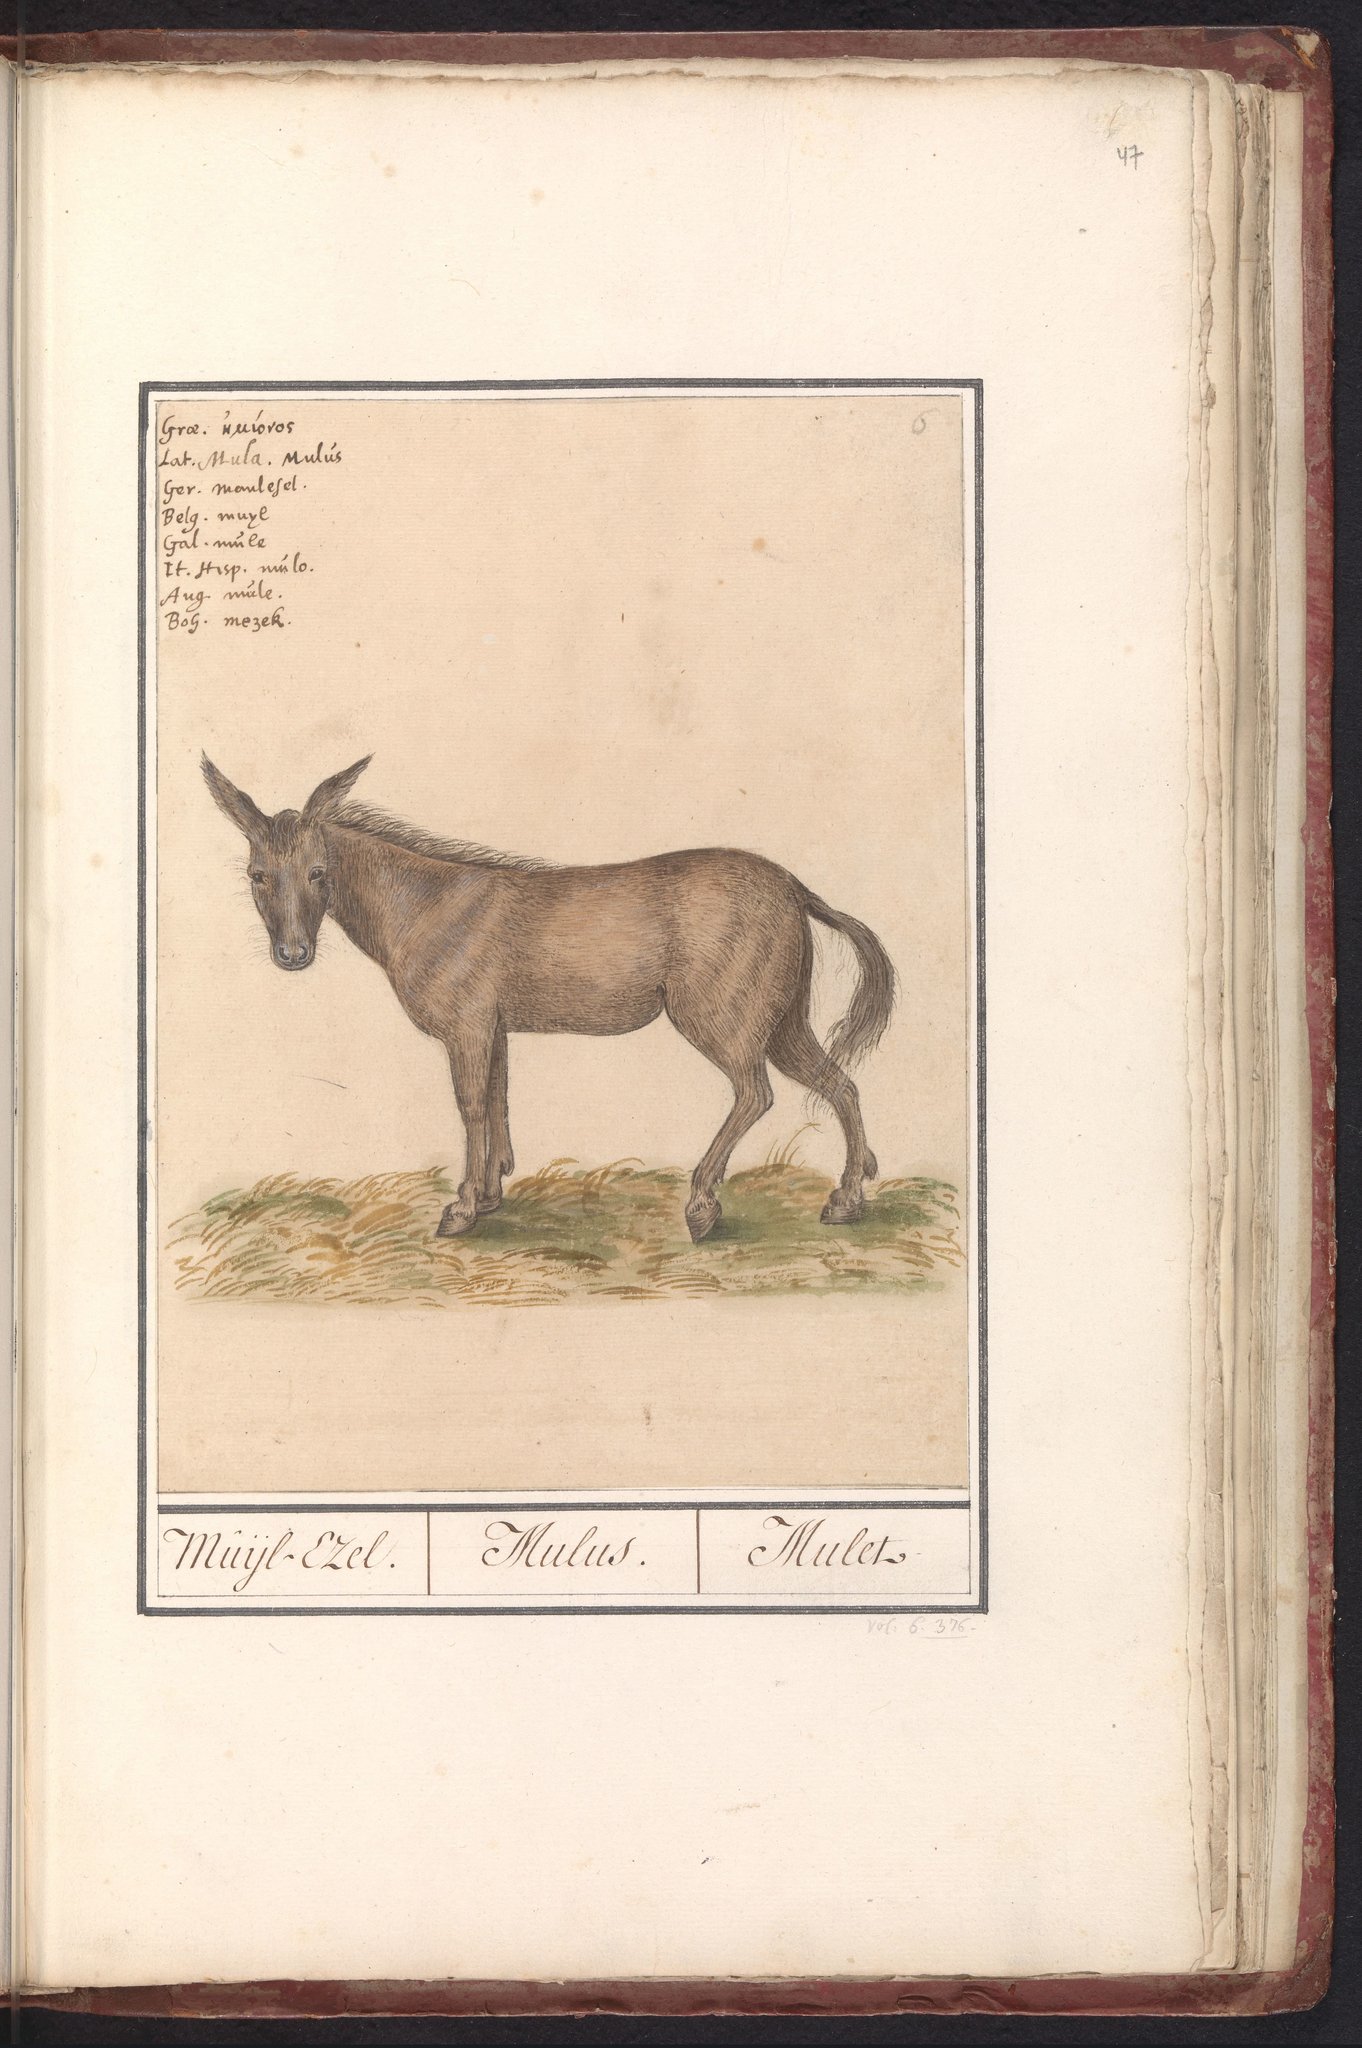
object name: drawing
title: Muilezel (Equus mulus)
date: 1596-1610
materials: paint, ink, paper, watercolor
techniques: brush, pen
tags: mule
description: Muilezel. Genummerd rechtsboven: 6. Linksboven de naam in acht talen. Onderdeel van het tweede album met tekeningen van viervoeters. Tweede van twaalf albums met tekeningen van dieren, vogels en planten bekend rond 1600, gemaakt in opdracht van keizer Rudolf II. Met toelichting in Nederlands, Latijn en Frans.